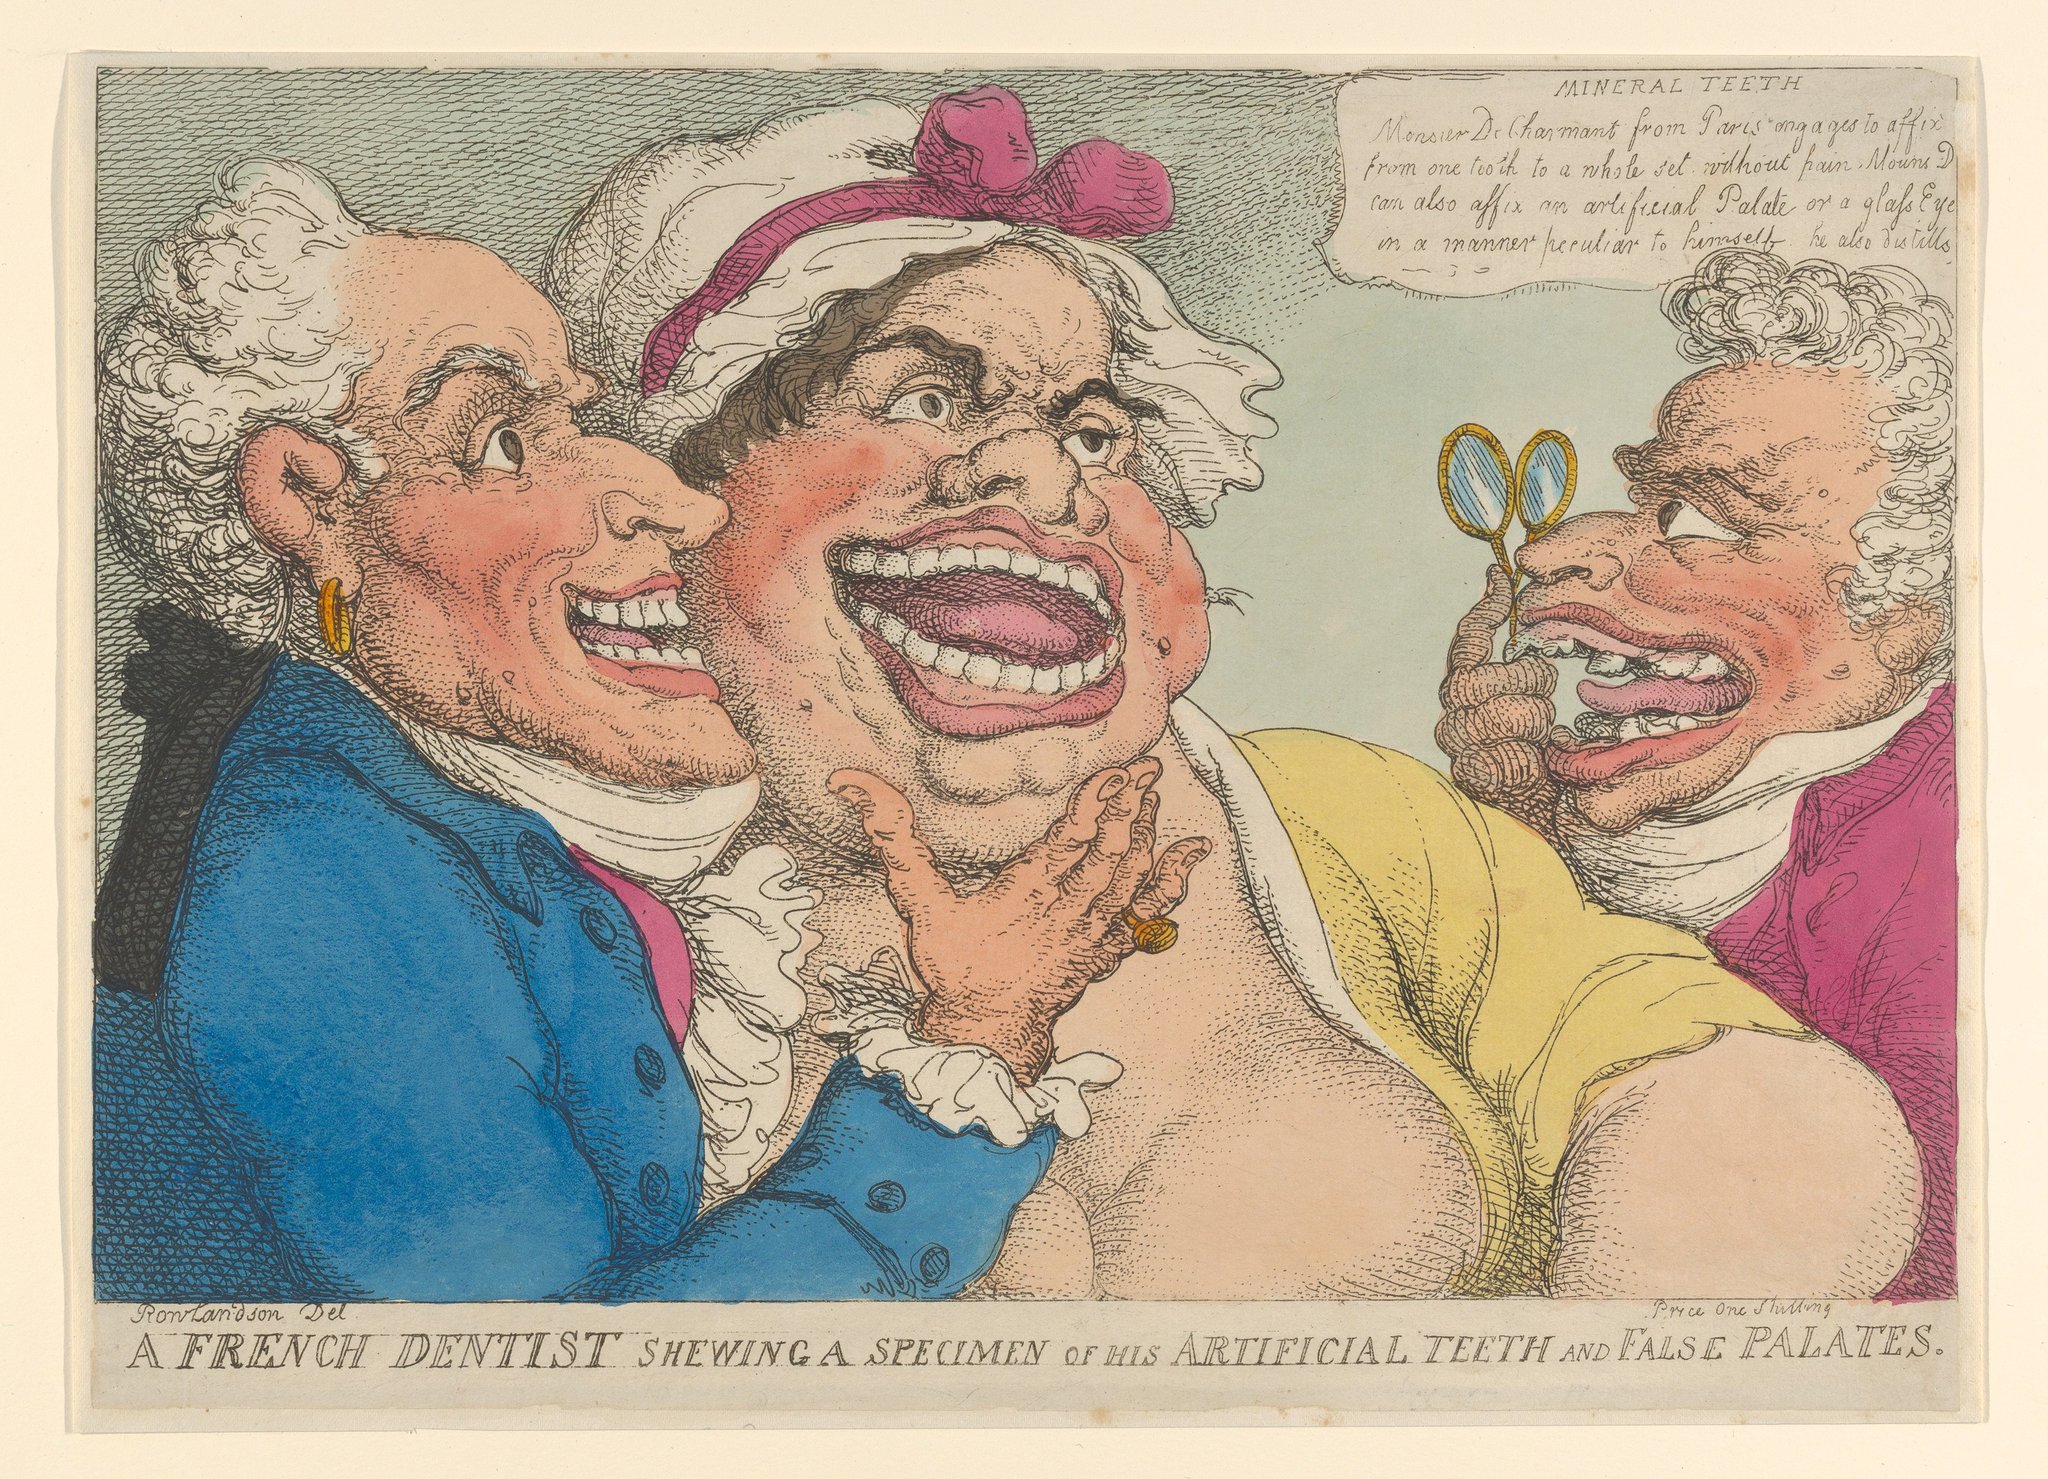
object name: print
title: A French Dentist Shewing a Specimen of His Artificial Teeth and False Palates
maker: thomas rowlandson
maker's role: artist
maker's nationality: british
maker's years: 1757-1827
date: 1811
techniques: etching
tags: satire,men,women